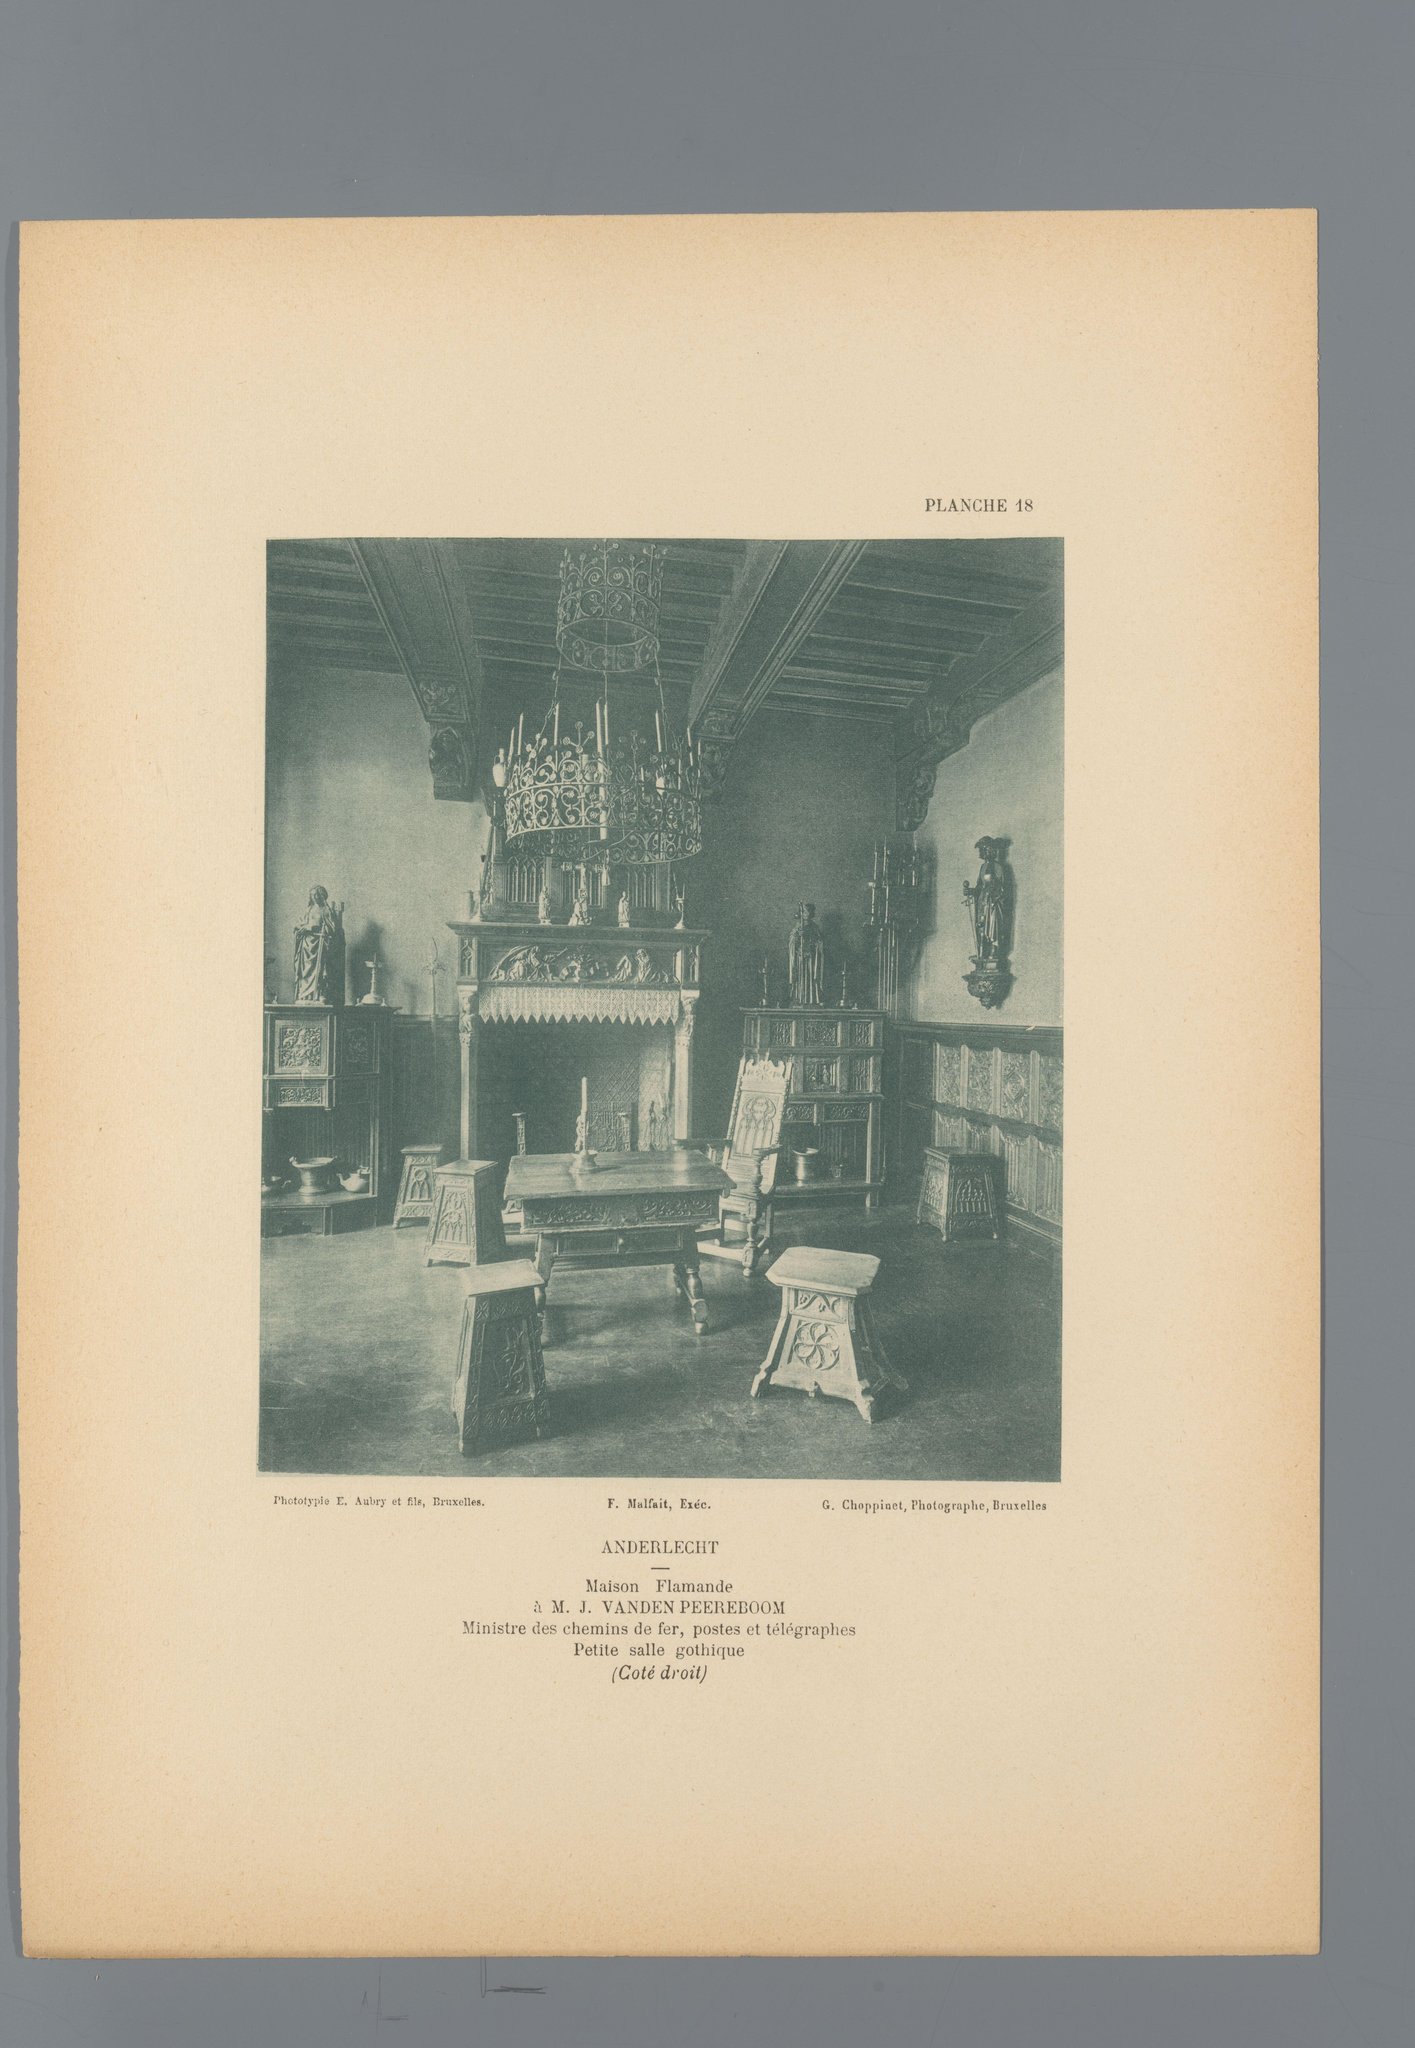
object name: photomechanical print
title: Anderlecht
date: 1893-1898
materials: paper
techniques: photograph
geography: anderlecht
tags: interior of the house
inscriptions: name: ‘F. Malfait, Exéc.’, number: ‘PLANCHE 18’, inscription: ‘Maison Flamande/ à M. J. VANDEN PEEREBOOM/ Ministre des chemins de fer, postes et télégraphes/ Petite salle gothique/ (Coté droit)’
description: Deze prent maakt deel uit van een omslag met 89 prenten en 5 tekstbladen.